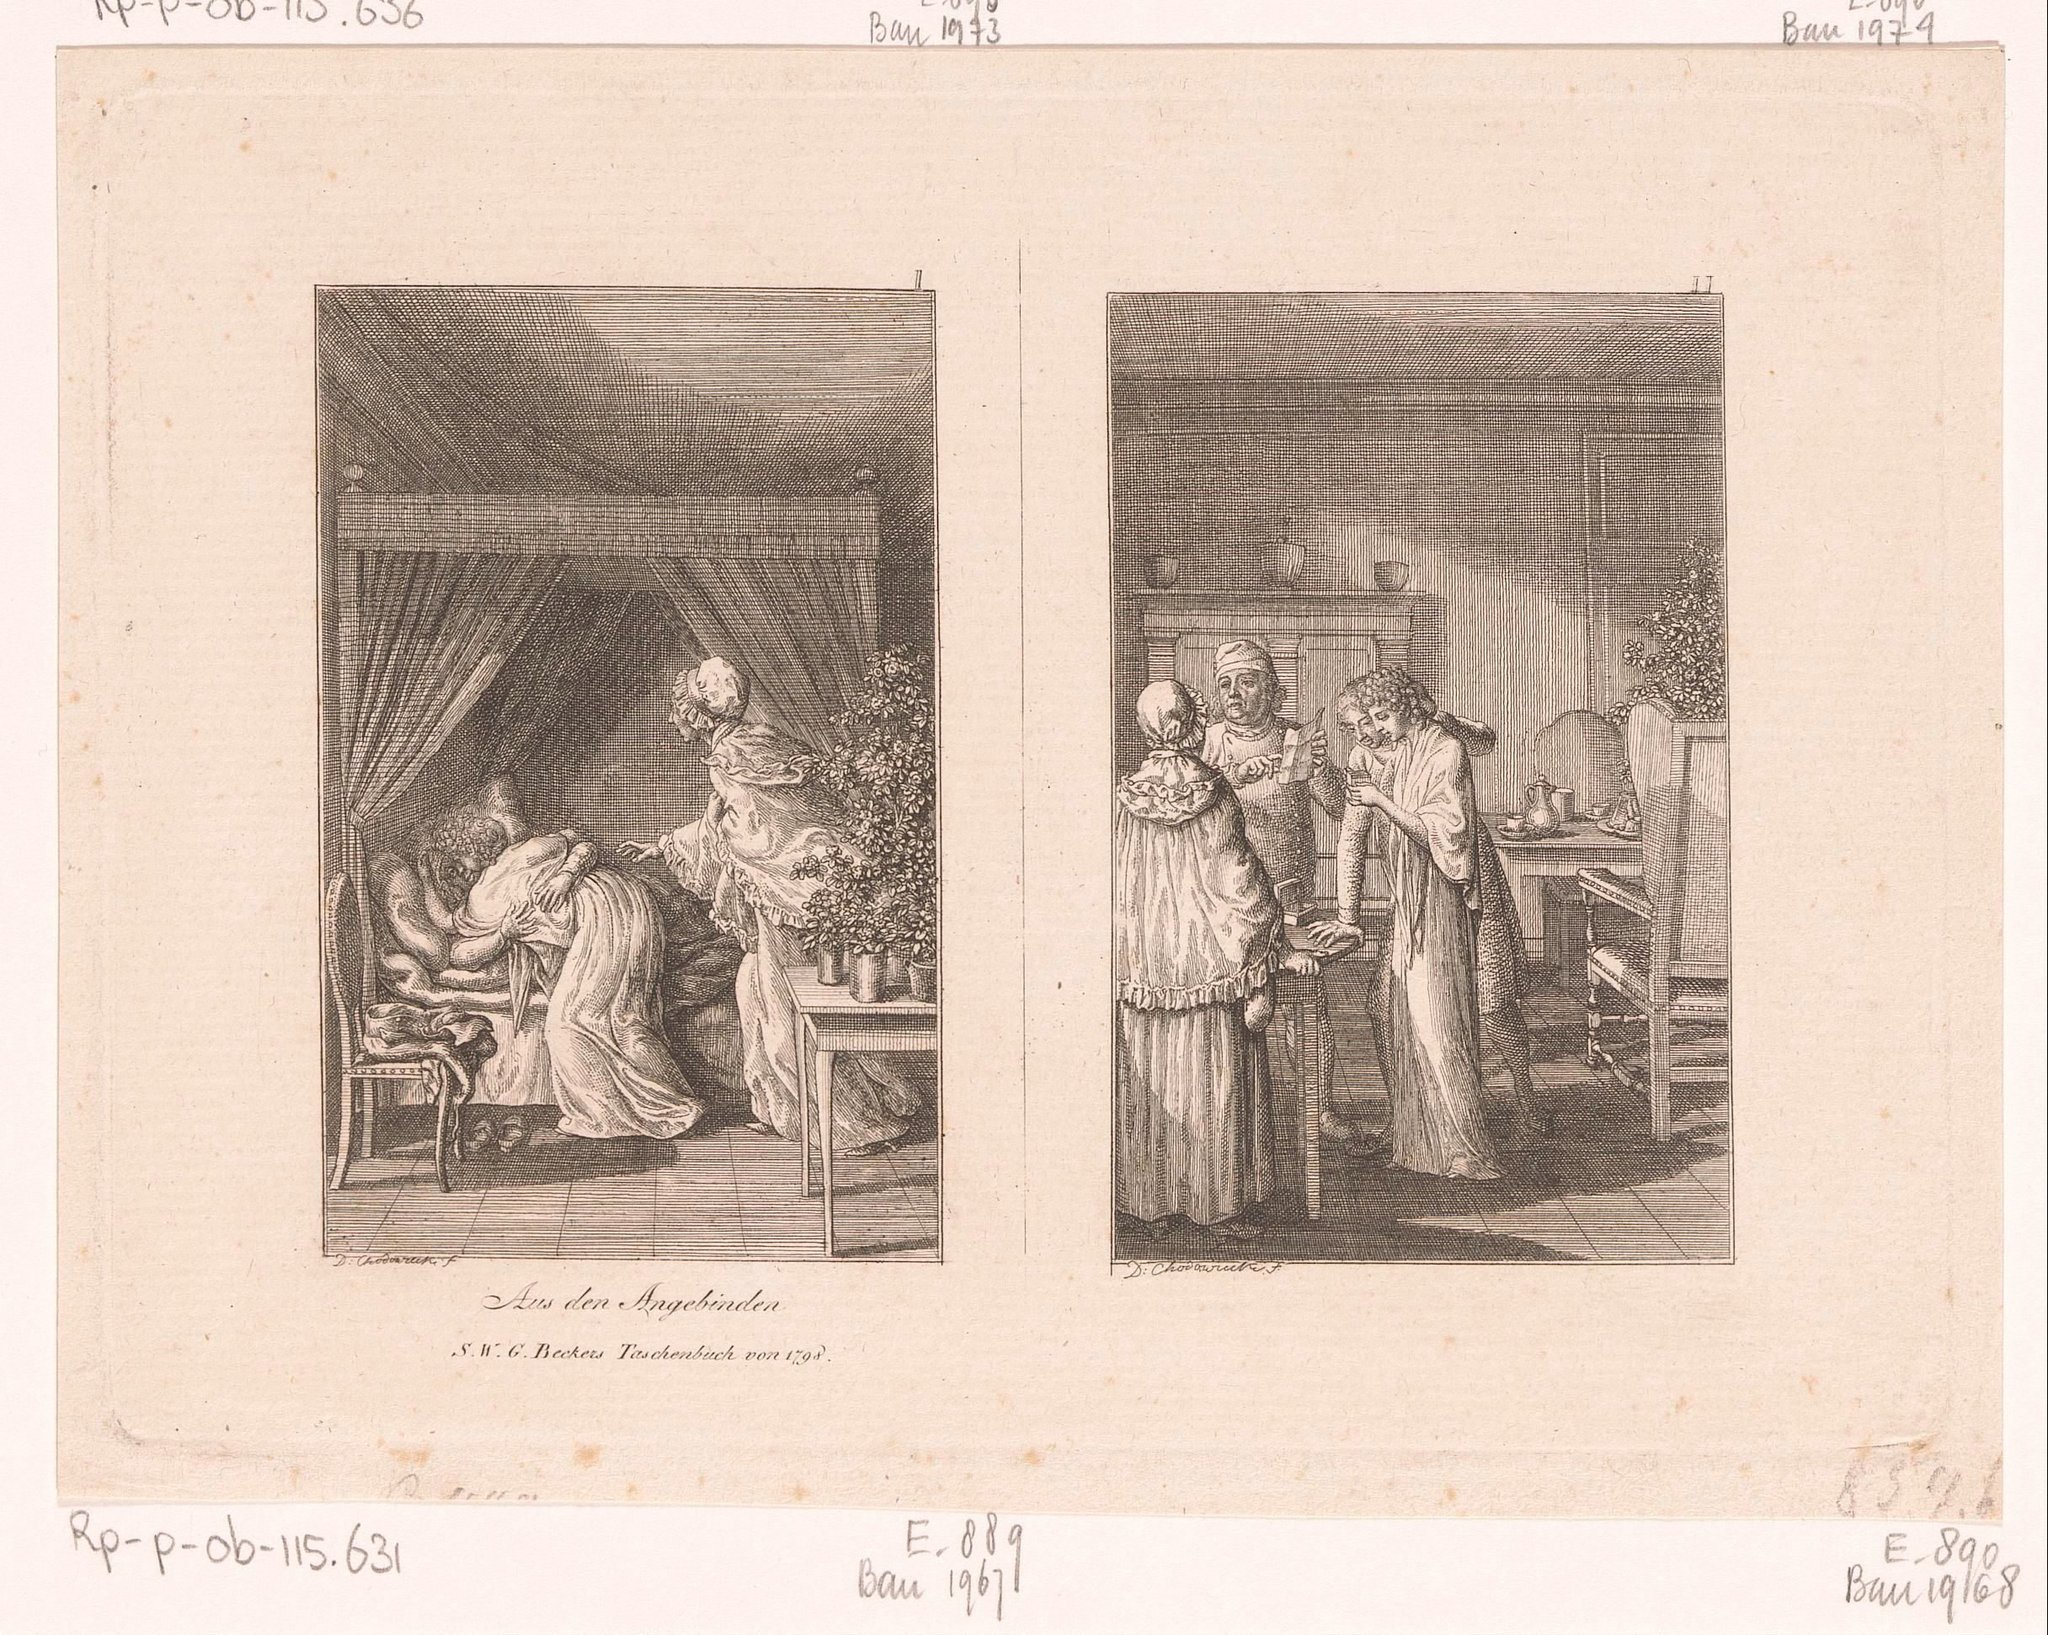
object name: print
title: Twee voorstellingen uit de verhalen van Wilhelm Gottlieb Becker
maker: daniel nikolaus chodowiecki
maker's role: draughtsman, print maker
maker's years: 1726-1801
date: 1798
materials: paper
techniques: etching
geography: berlin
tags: (lovers) embracing each other, 'symplegma', shrubs: rose-bush, letter, envelope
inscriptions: collector's mark: Lugt 2228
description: Prent gebruikt voor: Becker, Wilhelm Gottlieb. Almanach für 1798. Leipzig: s.n.s.a.